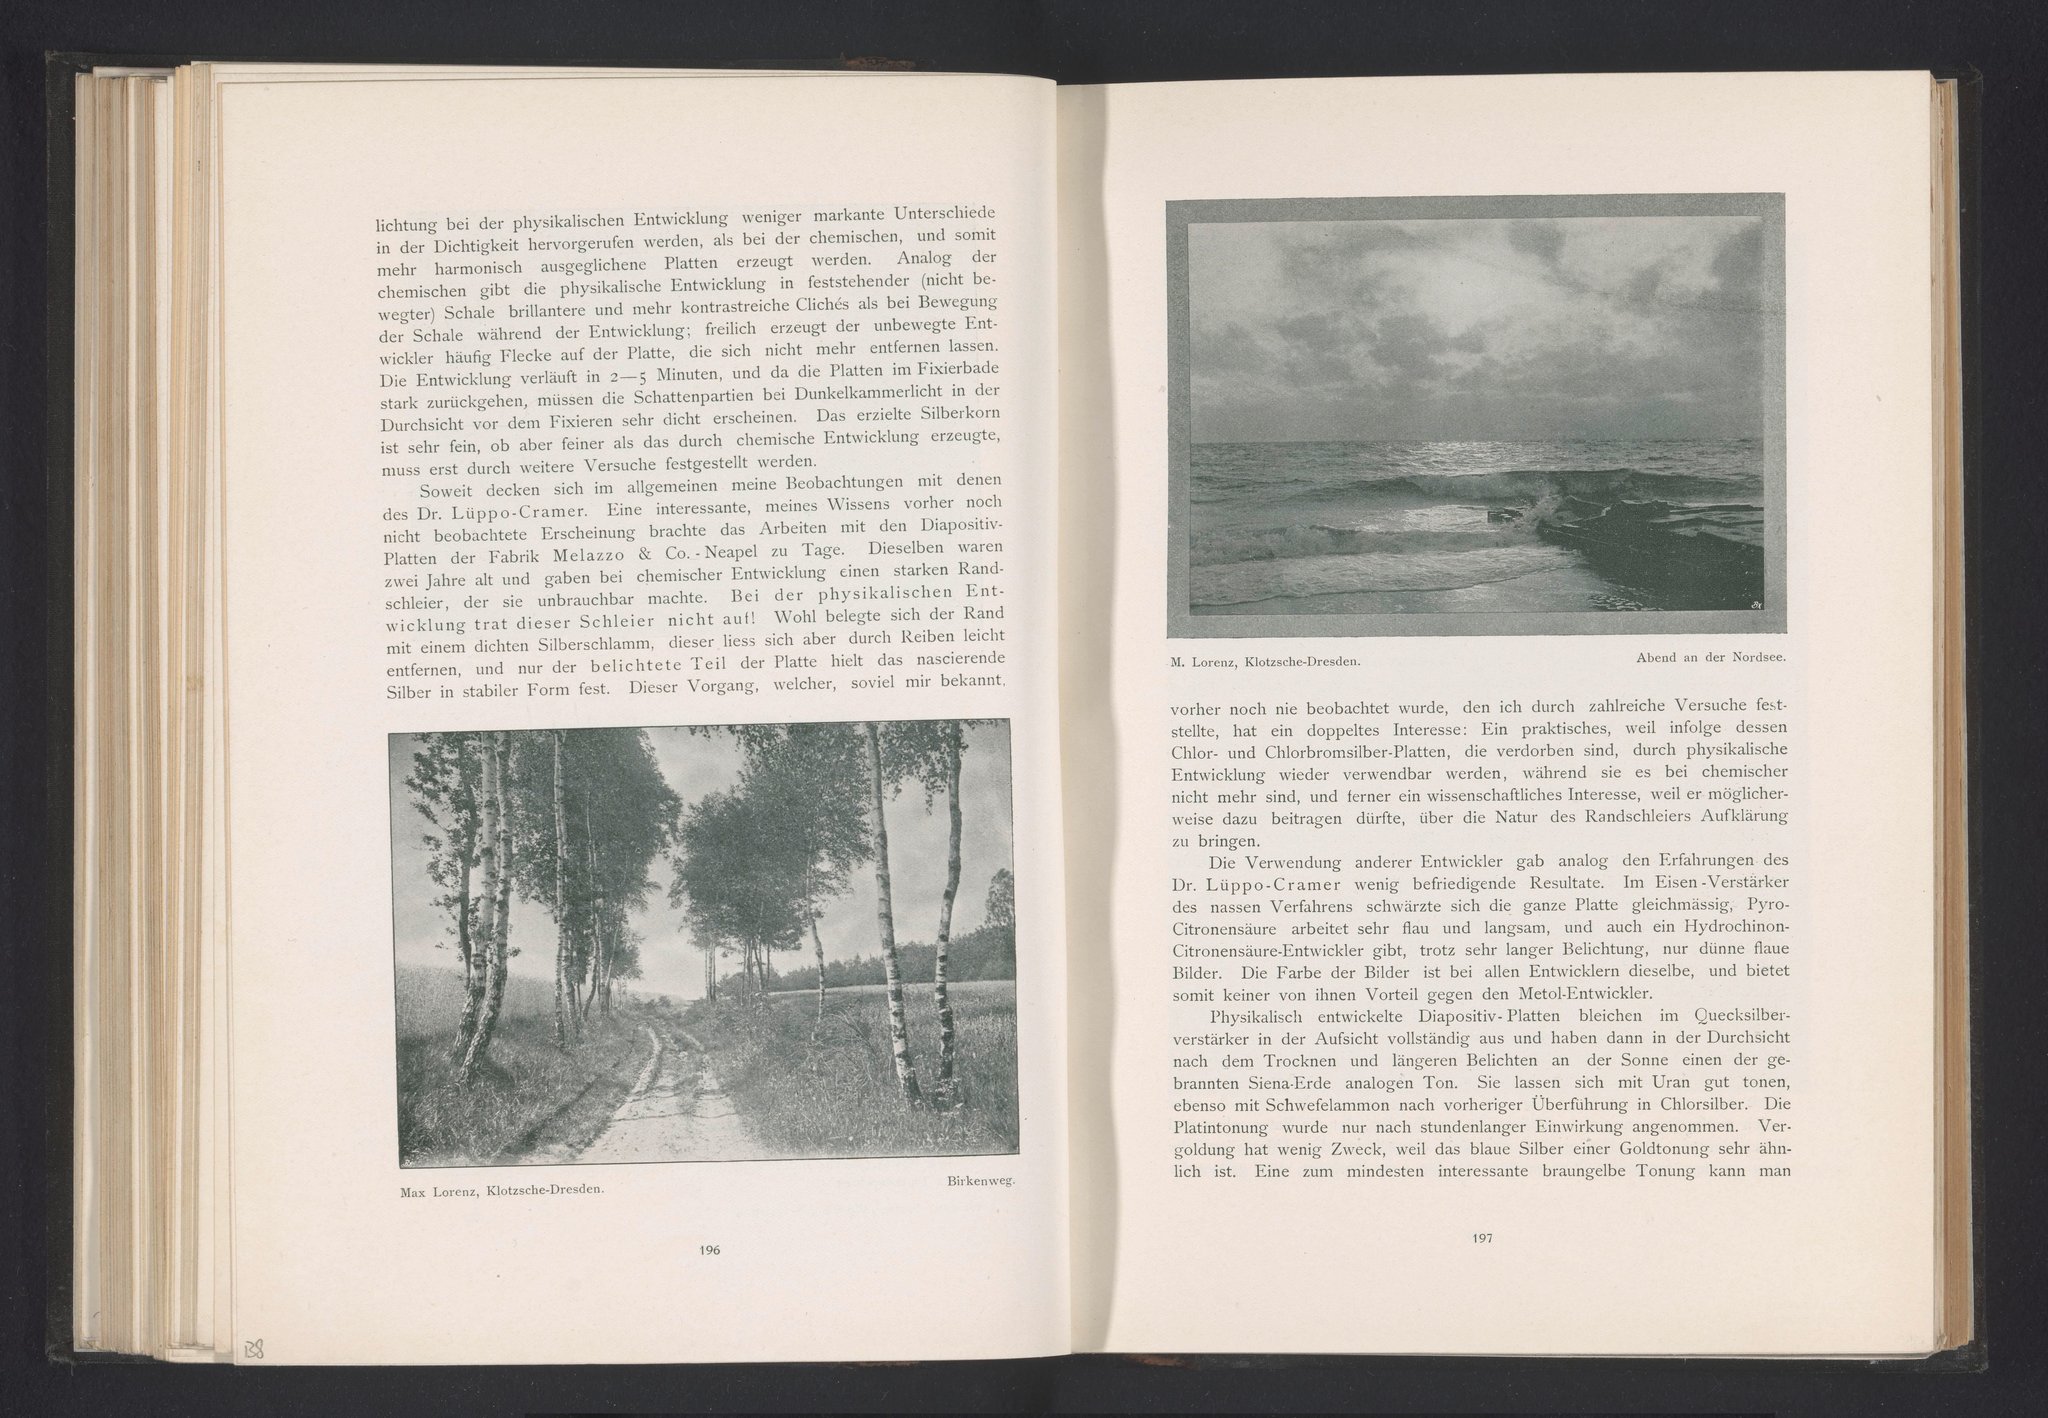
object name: page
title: Birkenweg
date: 1898-1903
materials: paper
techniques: autotype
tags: road, path, trees: birch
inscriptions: monogram: ‘BX’